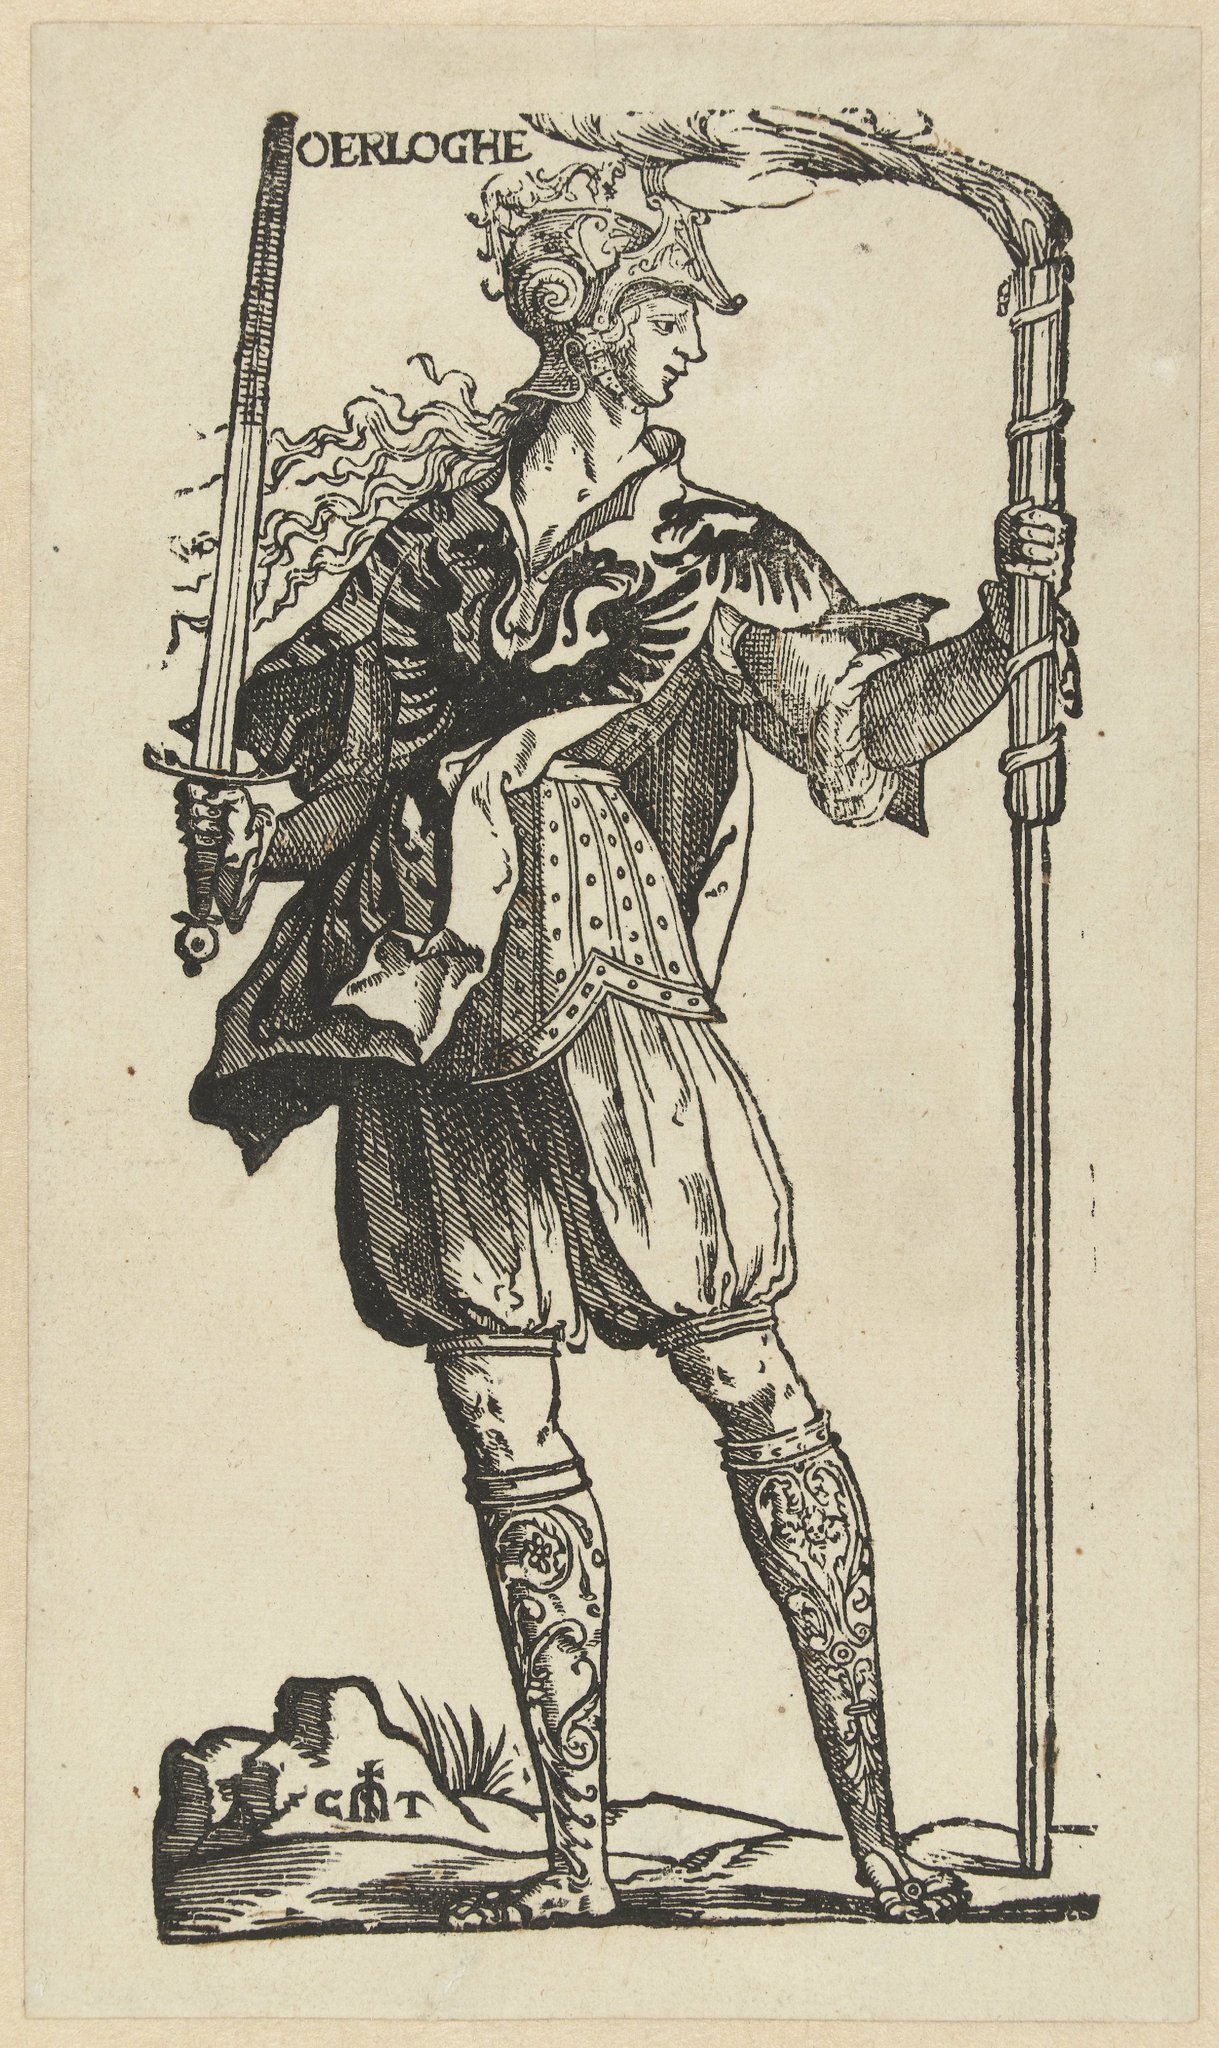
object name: print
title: Oorloghe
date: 1546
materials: paper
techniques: woodcut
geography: low countries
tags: symbols, allegories of war; 'guerra' (ripa)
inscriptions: collector's mark: Lugt 2228a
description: Deel van de serie Misbruik van Voorspoed, maar hier gedrukt als zelfstandige voorstelling, zonder omlijsting en tekst. Personificatie van de oorlog. Een vrouw van voren gezien, het hoofd en profiel naar rechts. Helm op het hoofd, in de rechterhand een zwaard en in de linker een brandende fakkel. Zij is in krijgstenue en heeft een wapenrok aan, waarop een wapen met twee adelaars.